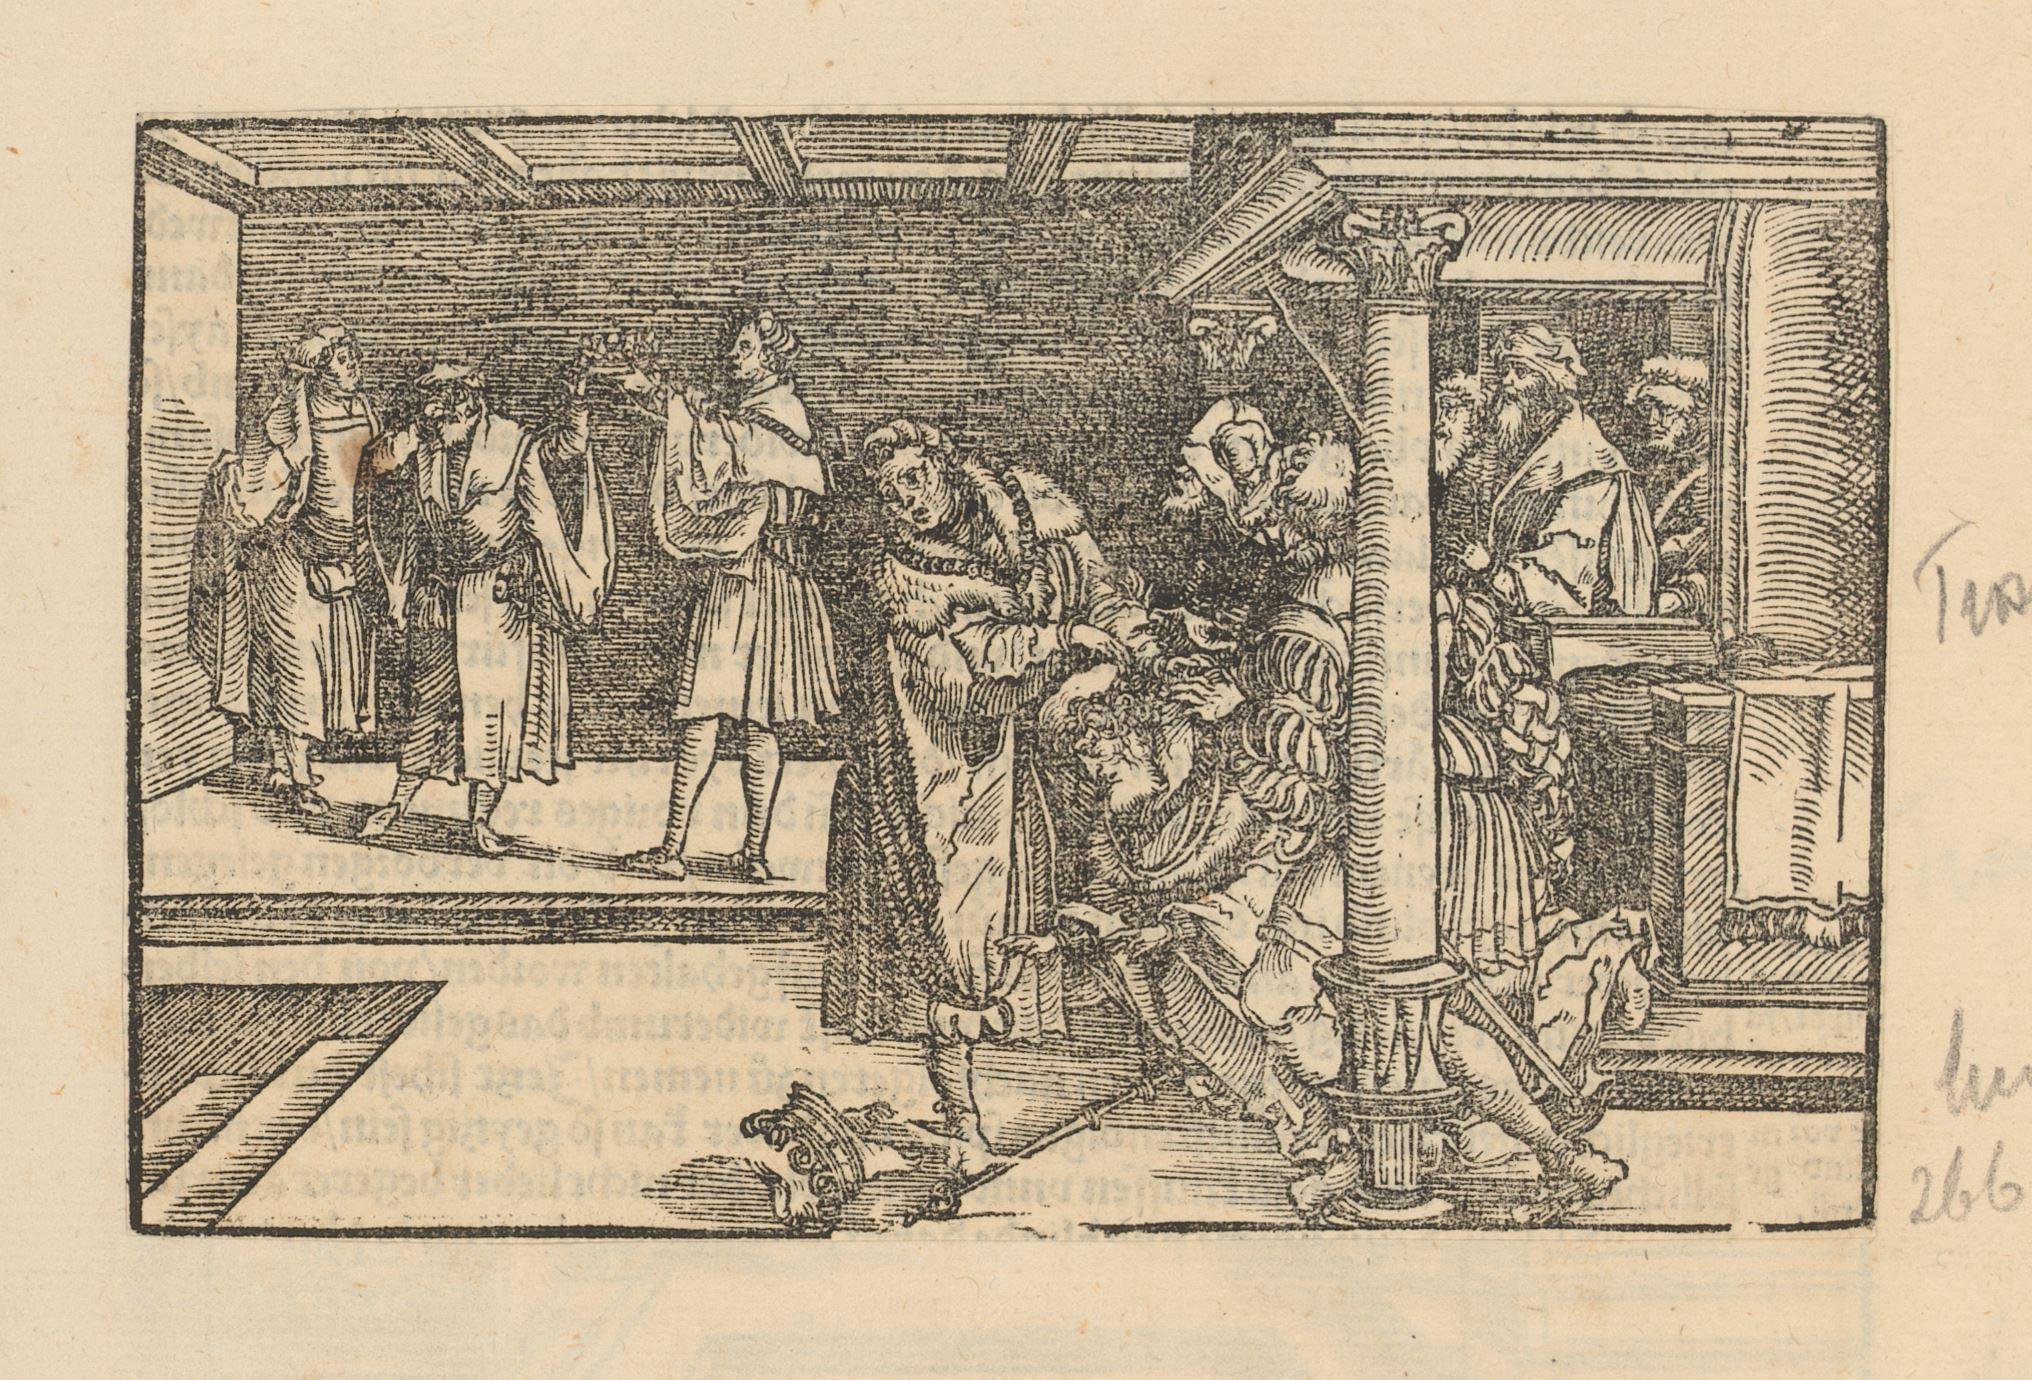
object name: album leaf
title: Koning wordt van zijn troon gesleurd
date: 1514-1532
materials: paper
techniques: letterpress printing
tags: attempt, political murder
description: Deze prent is gebruikt in: Petrarca, Francesco. Von der Artzney bayder Glück, des guten und widerwertigen: unnd weß sich ain yeder inn Gelück und Unglück halten sol (...). Augsburg: Heinrich Steiner, 1532. Deze uitgave is ook bekend onder de titel 'Trostspiegel in Glück und Unglück'. Deze prent is ook gebruikt in: Cicero, Marcus Tulius. Officia M.T.C. Ein Buch so Marcus Tullius Cicero der Römer zu seynem (...). [Vertaald uit het Latijn door] Johann von Schwarzenberg. Augsburg: Heinrich Steiner, 1531.